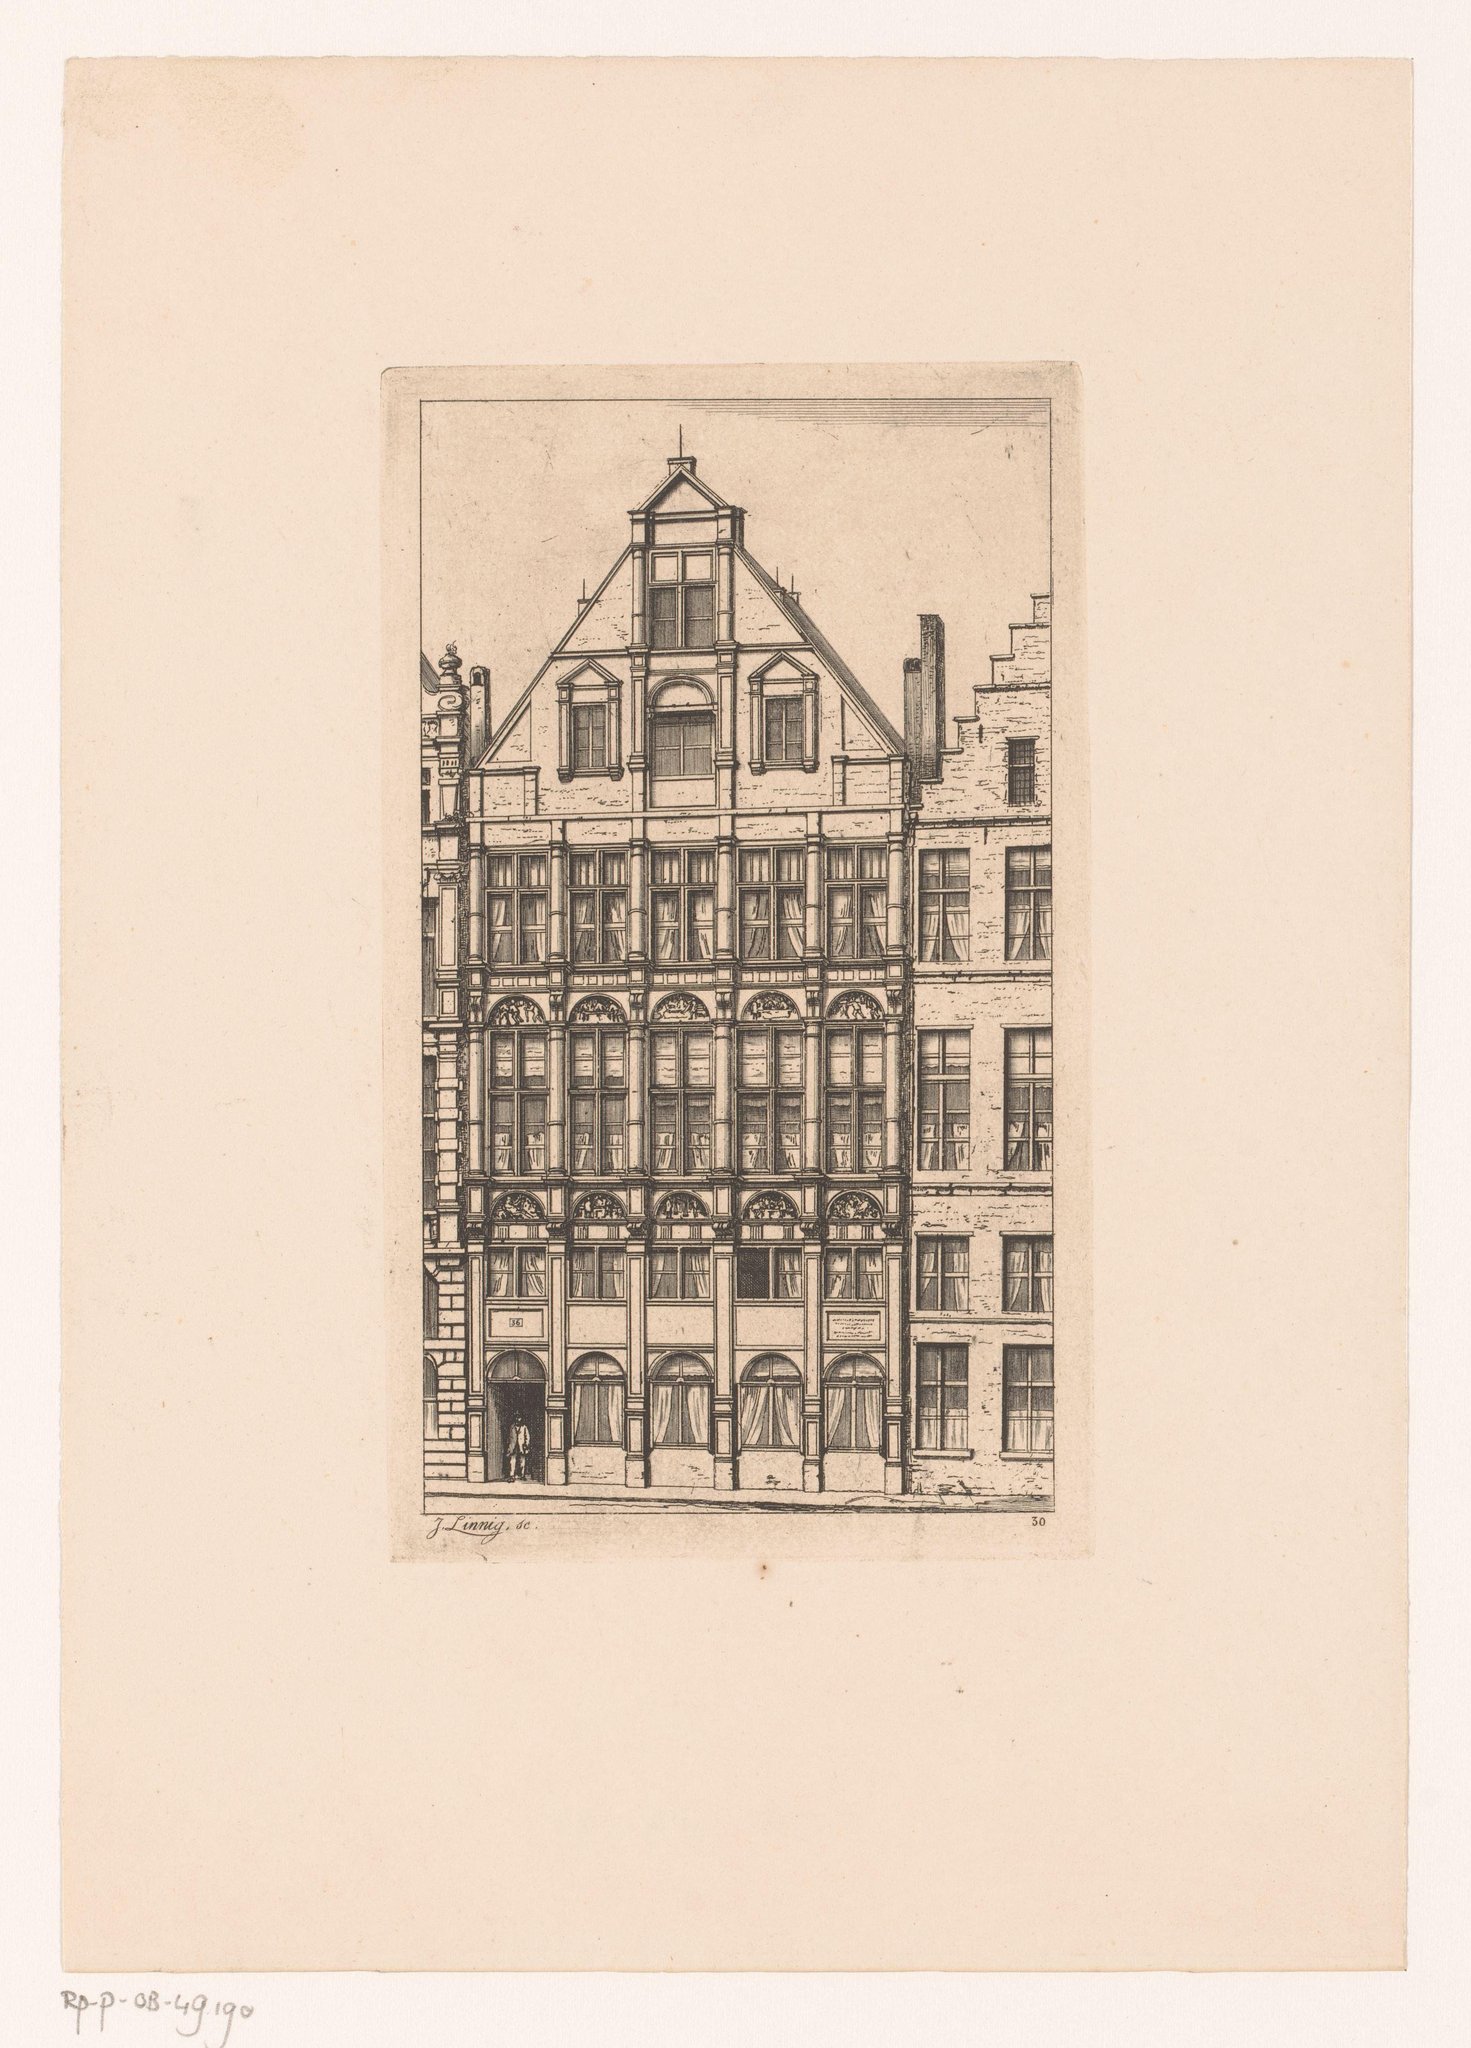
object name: print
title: Huis van het lakengilde op de Grote Markt in Antwerpen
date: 1868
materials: paper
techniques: etching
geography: antwerp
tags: façade (of house or building), street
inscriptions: collector's mark: Lugt 2228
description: Prent uit: Mertens, F.H. Album historique de la ville d'Anvers [...]. Antwerpen: J.E. Buschmann, 1868.